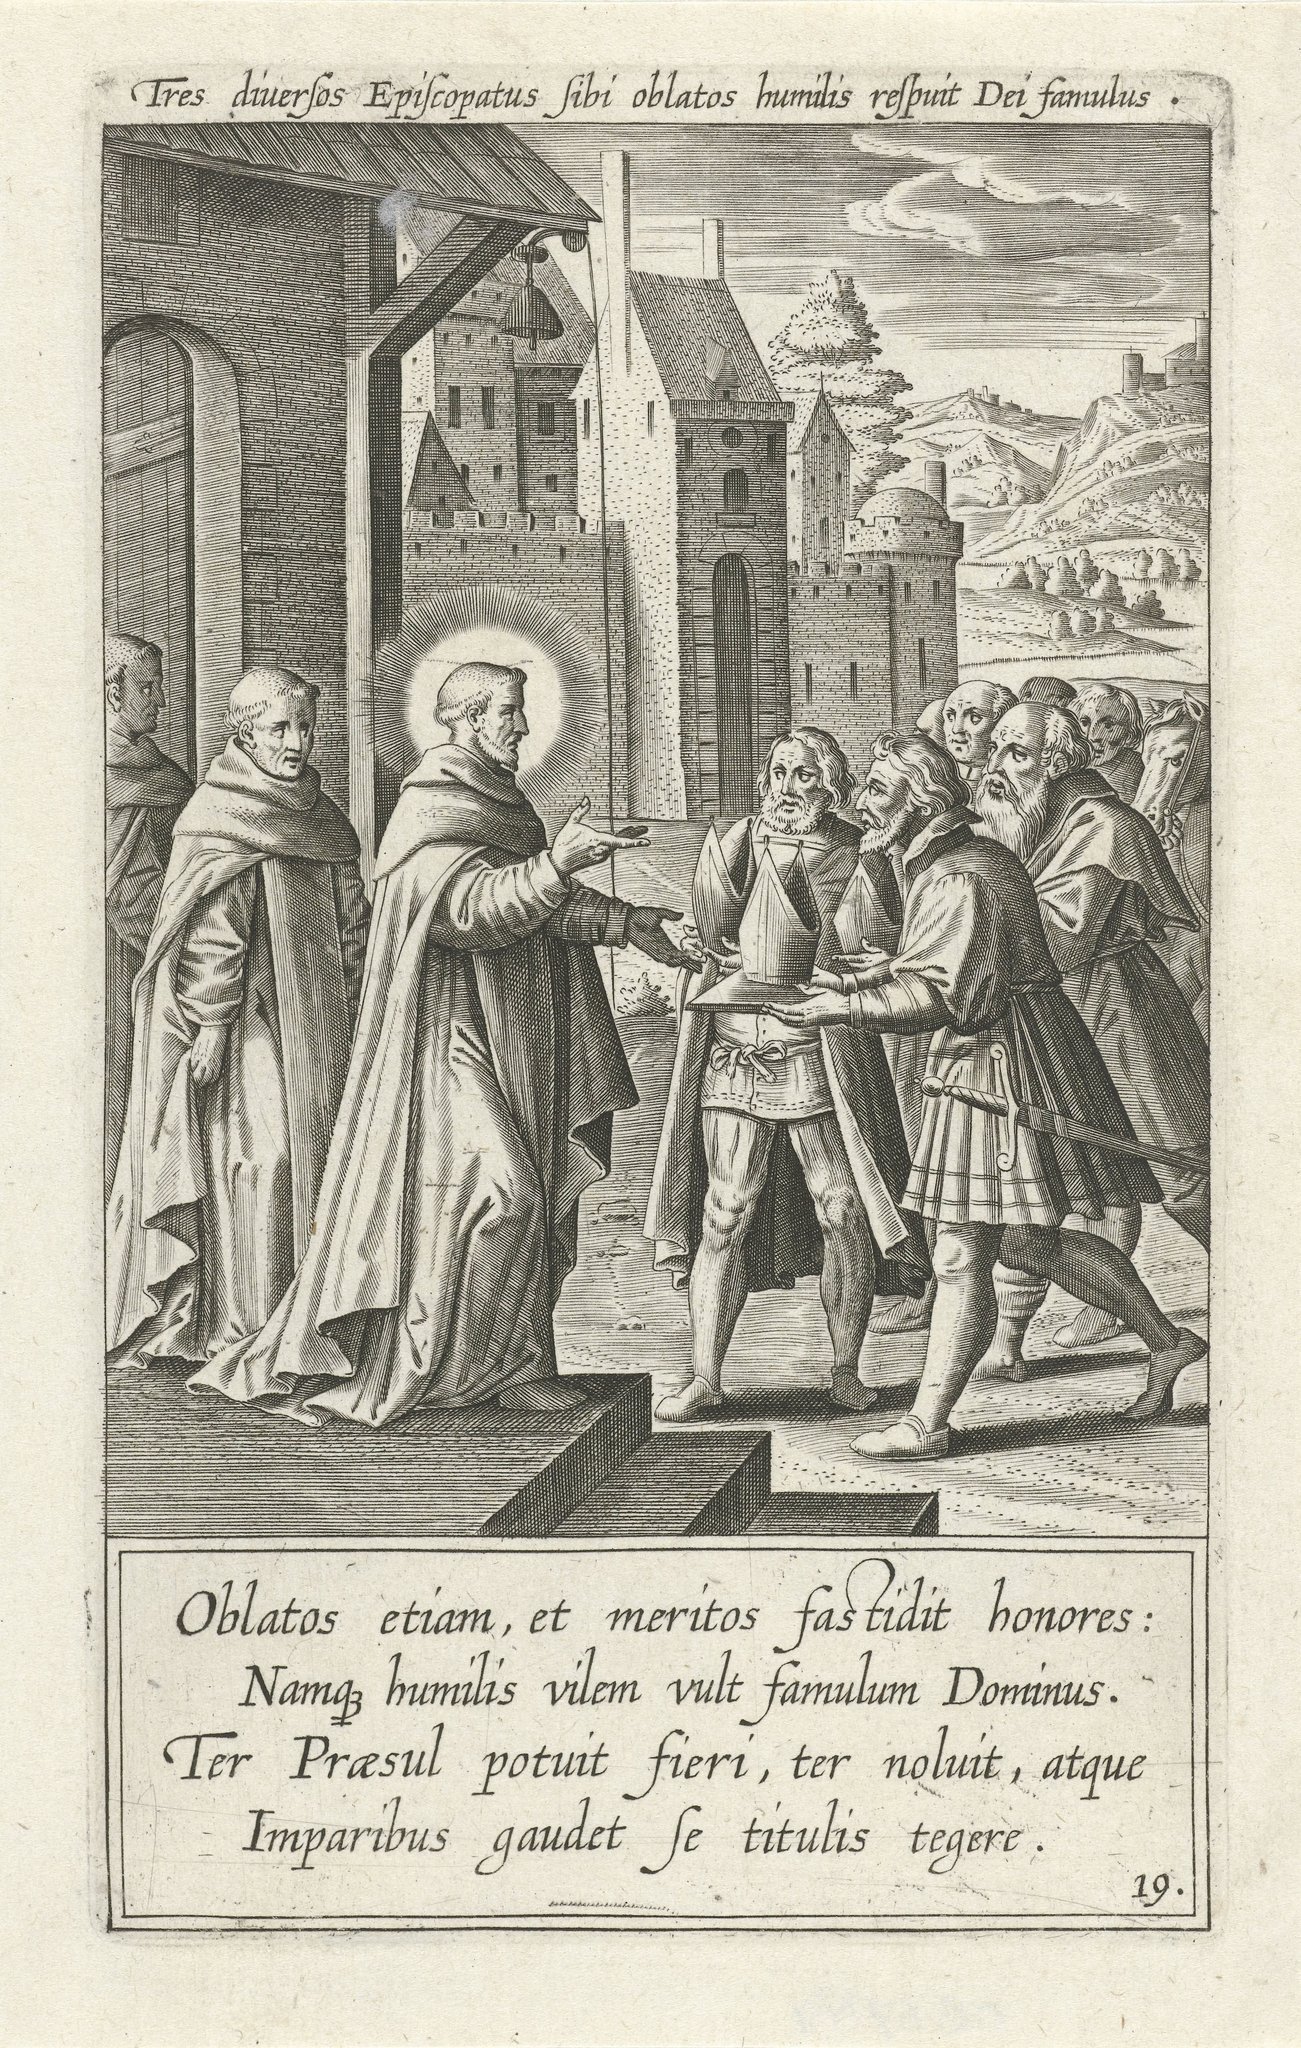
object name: book illustration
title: Leven en mirakels van de heilige Dominicus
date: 1611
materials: paper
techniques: engraving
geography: poland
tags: non-miraculous activities and events ~ st. dominic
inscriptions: collector's mark: Lugt 2228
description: Afgevaardigden van het bisdom Conserano bieden de heilige Dominicus de bisschopsmijter van Conserano aan. De heilige Dominicus weigert deze te aanvaarden. De prent heeft een Latijns opschrift en onderschrift en maakt deel uit van een prentserie voor een boek over het leven van de heilige Dominicus.